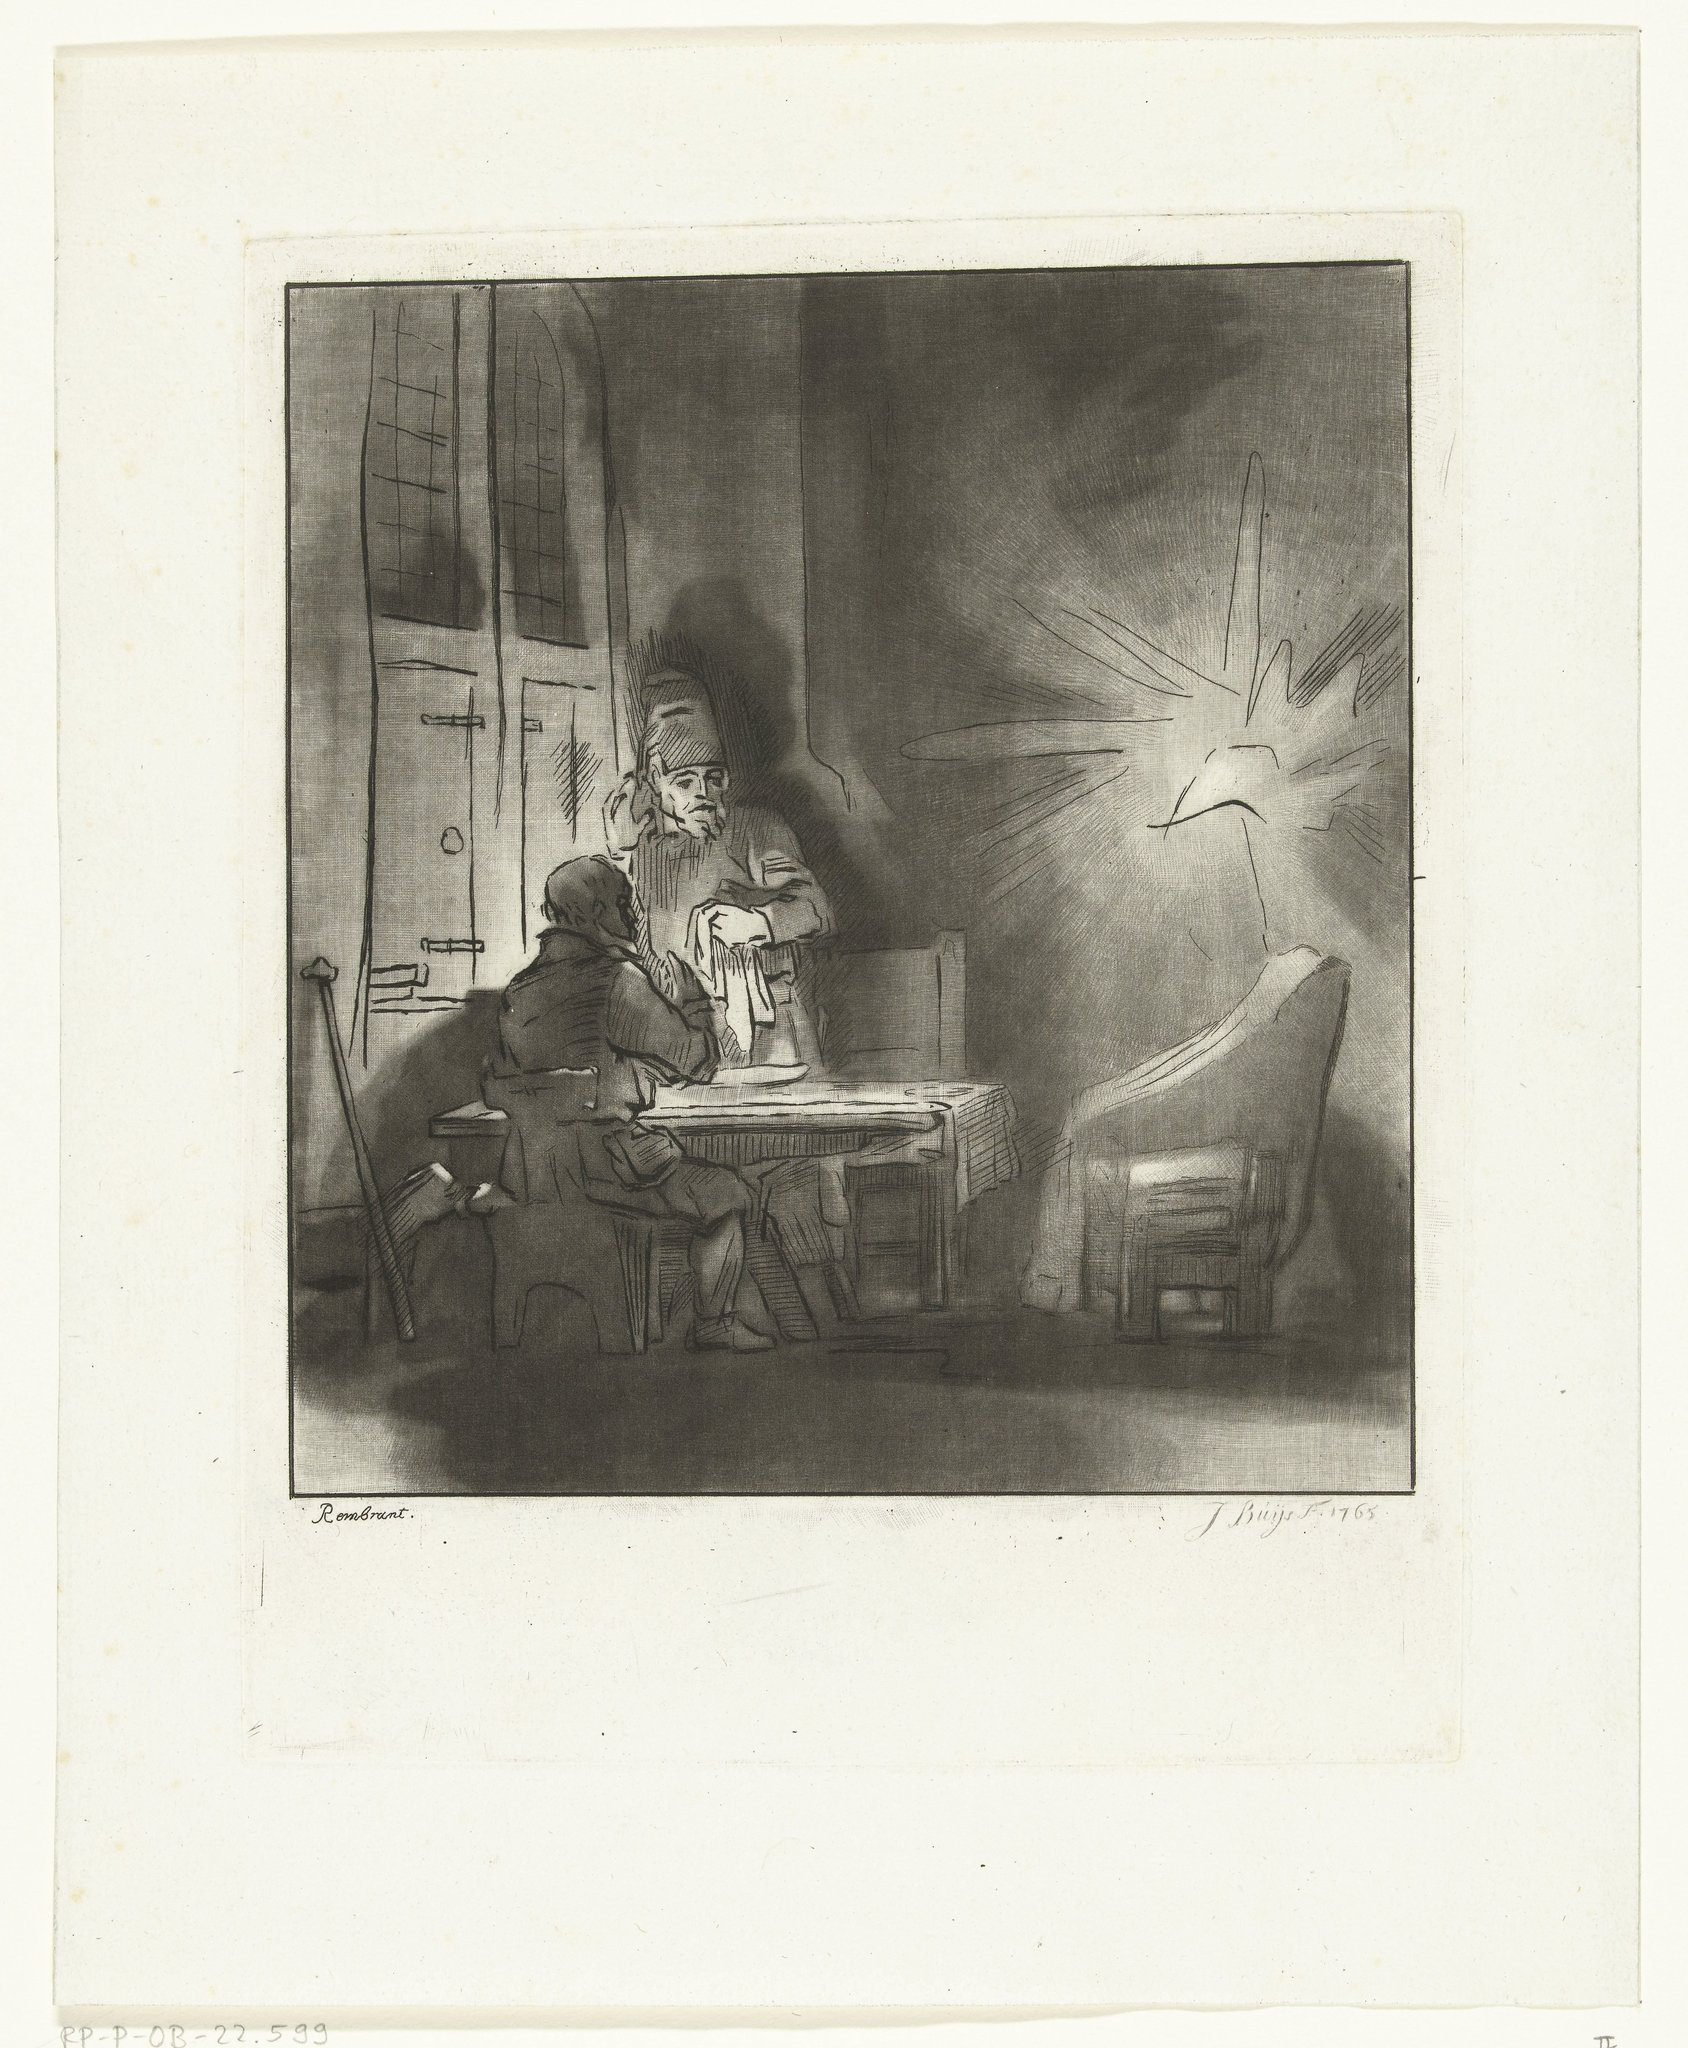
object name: print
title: De maaltijd te Emmaüs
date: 1765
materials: paper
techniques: aquatint, etching, roulette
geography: amsterdam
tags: the supper at emmaus: christ is recognized while blessing or breaking the bread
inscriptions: collector's mark: Lugt 240